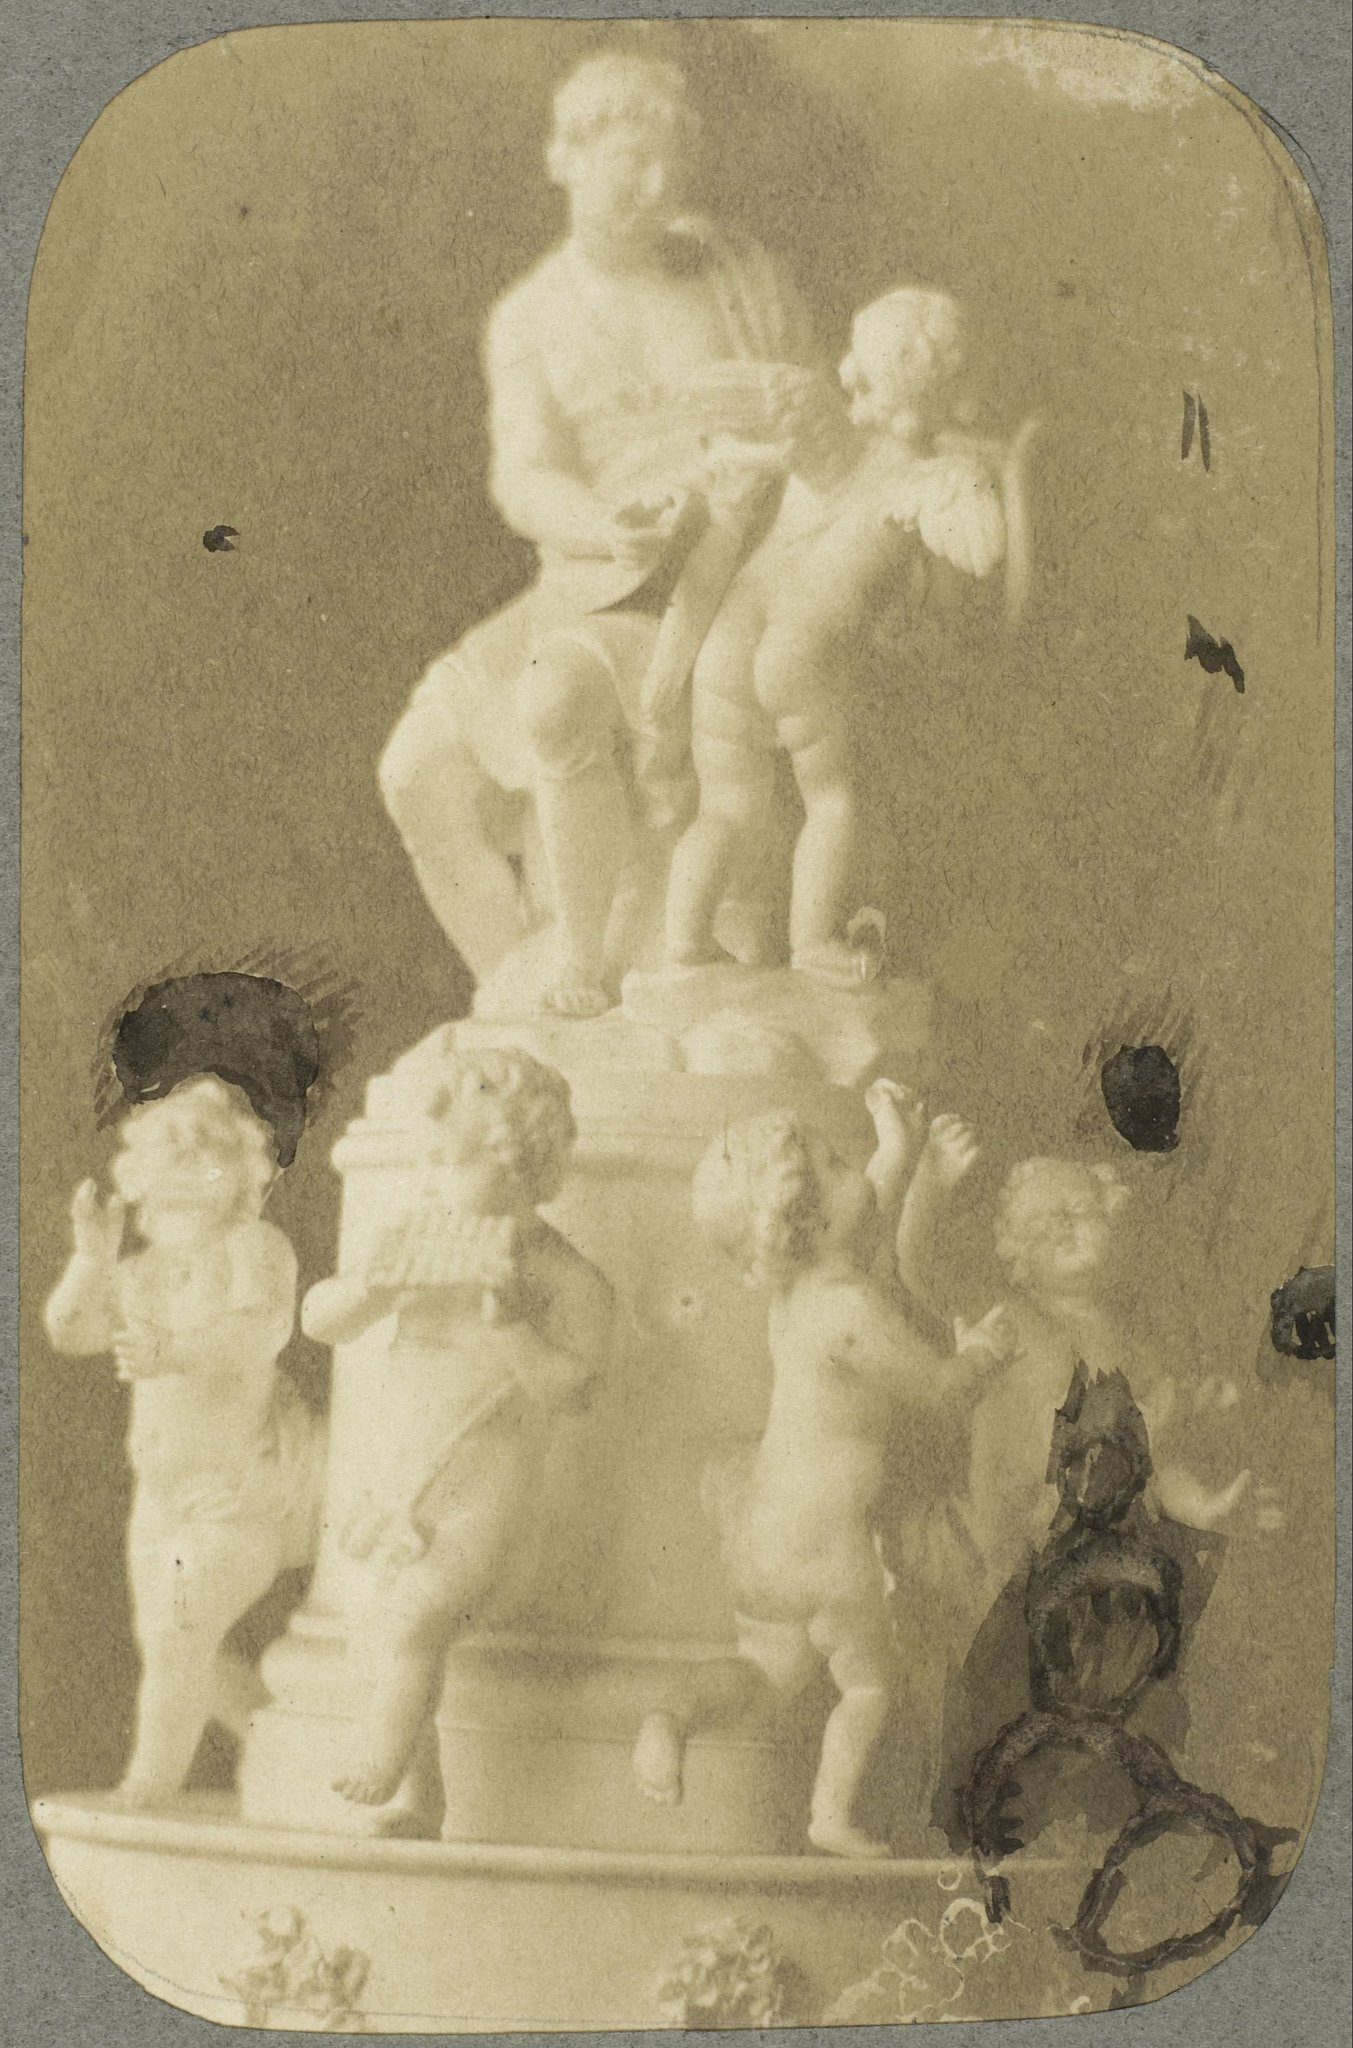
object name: photograph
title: Pleisterkopie met muziek makende putti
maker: eduard isaac asser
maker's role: amateurfotograaf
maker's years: 1809-1894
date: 1850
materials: cardboard, paper, photographic support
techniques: salted paper print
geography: amsterdam